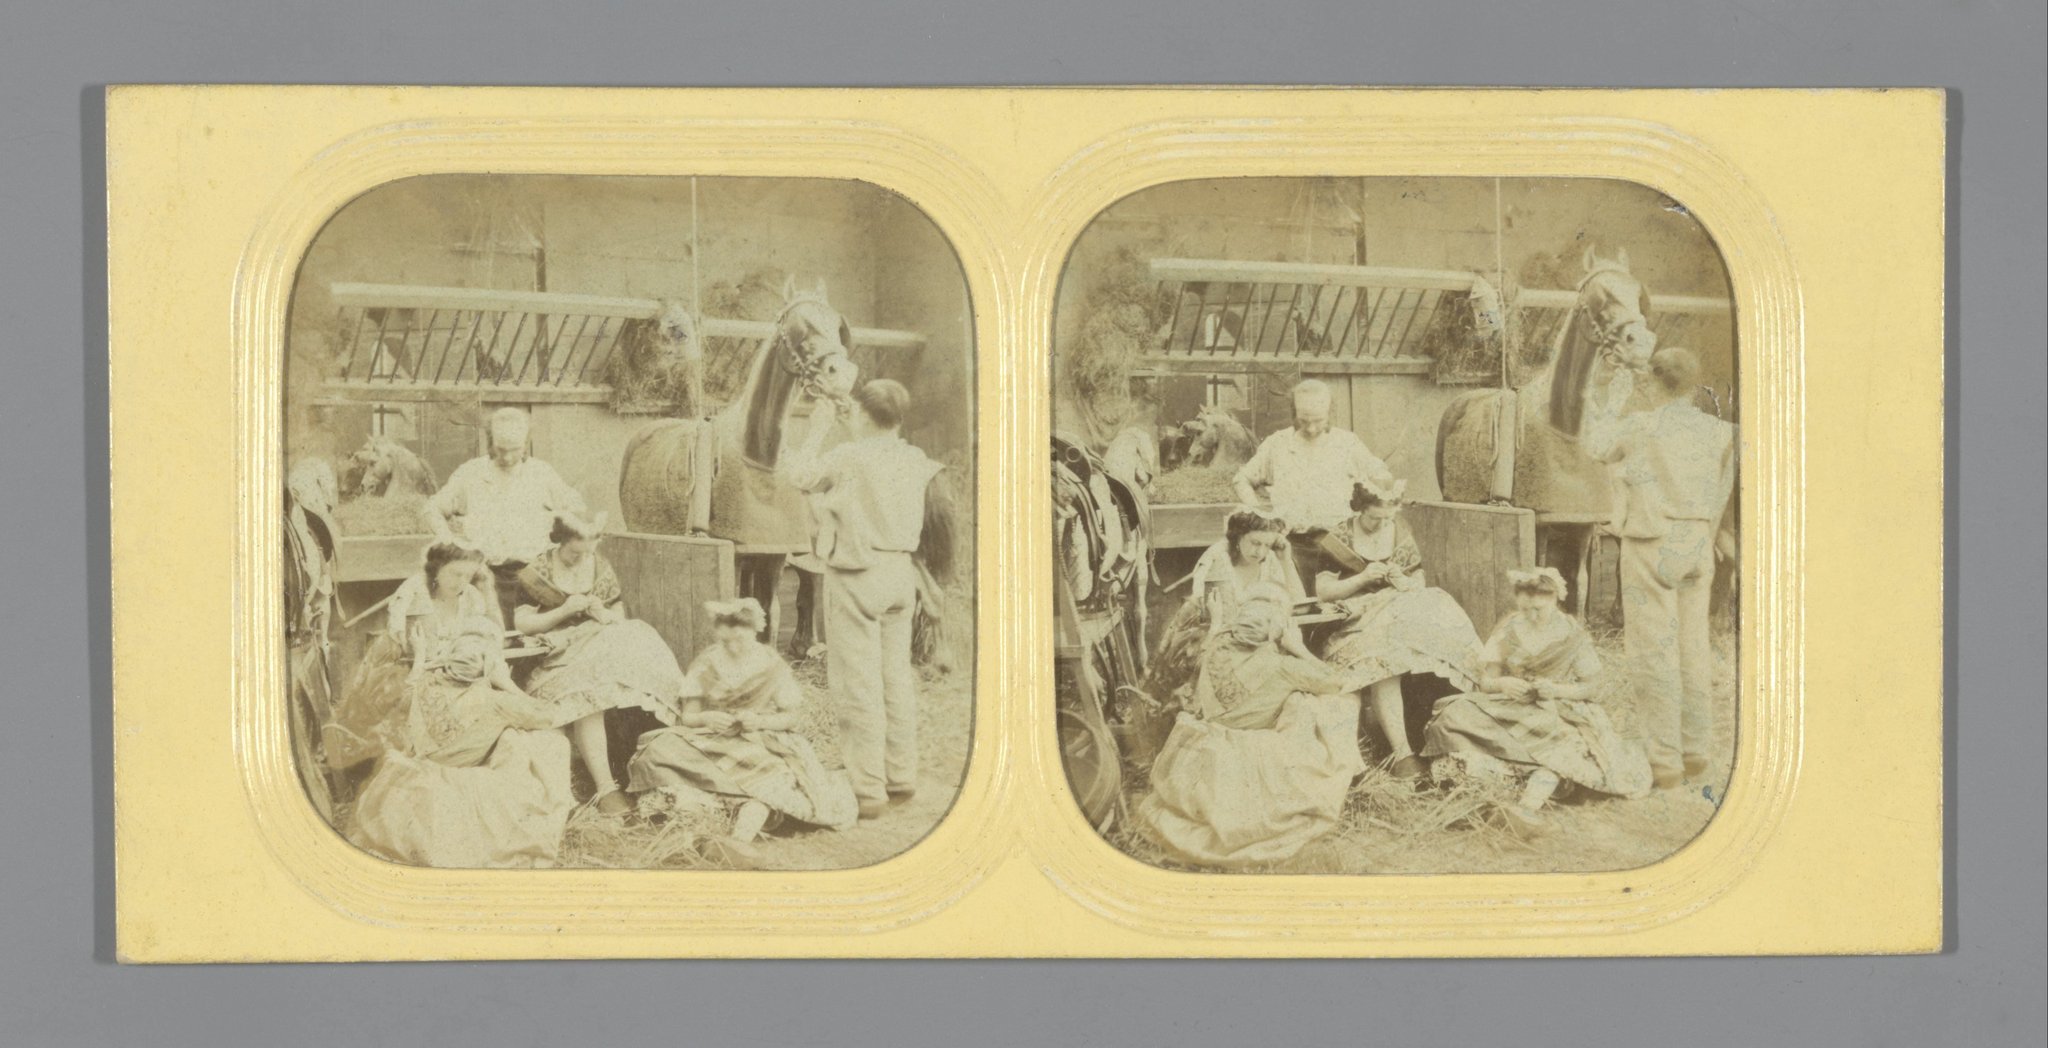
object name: tissue stereograph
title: Vier vrouwen, man en man met paard in een stal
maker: Anonymous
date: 1855-1875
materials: cardboard, paper, photographic support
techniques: albumen print, hand coloring, perforating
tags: barn